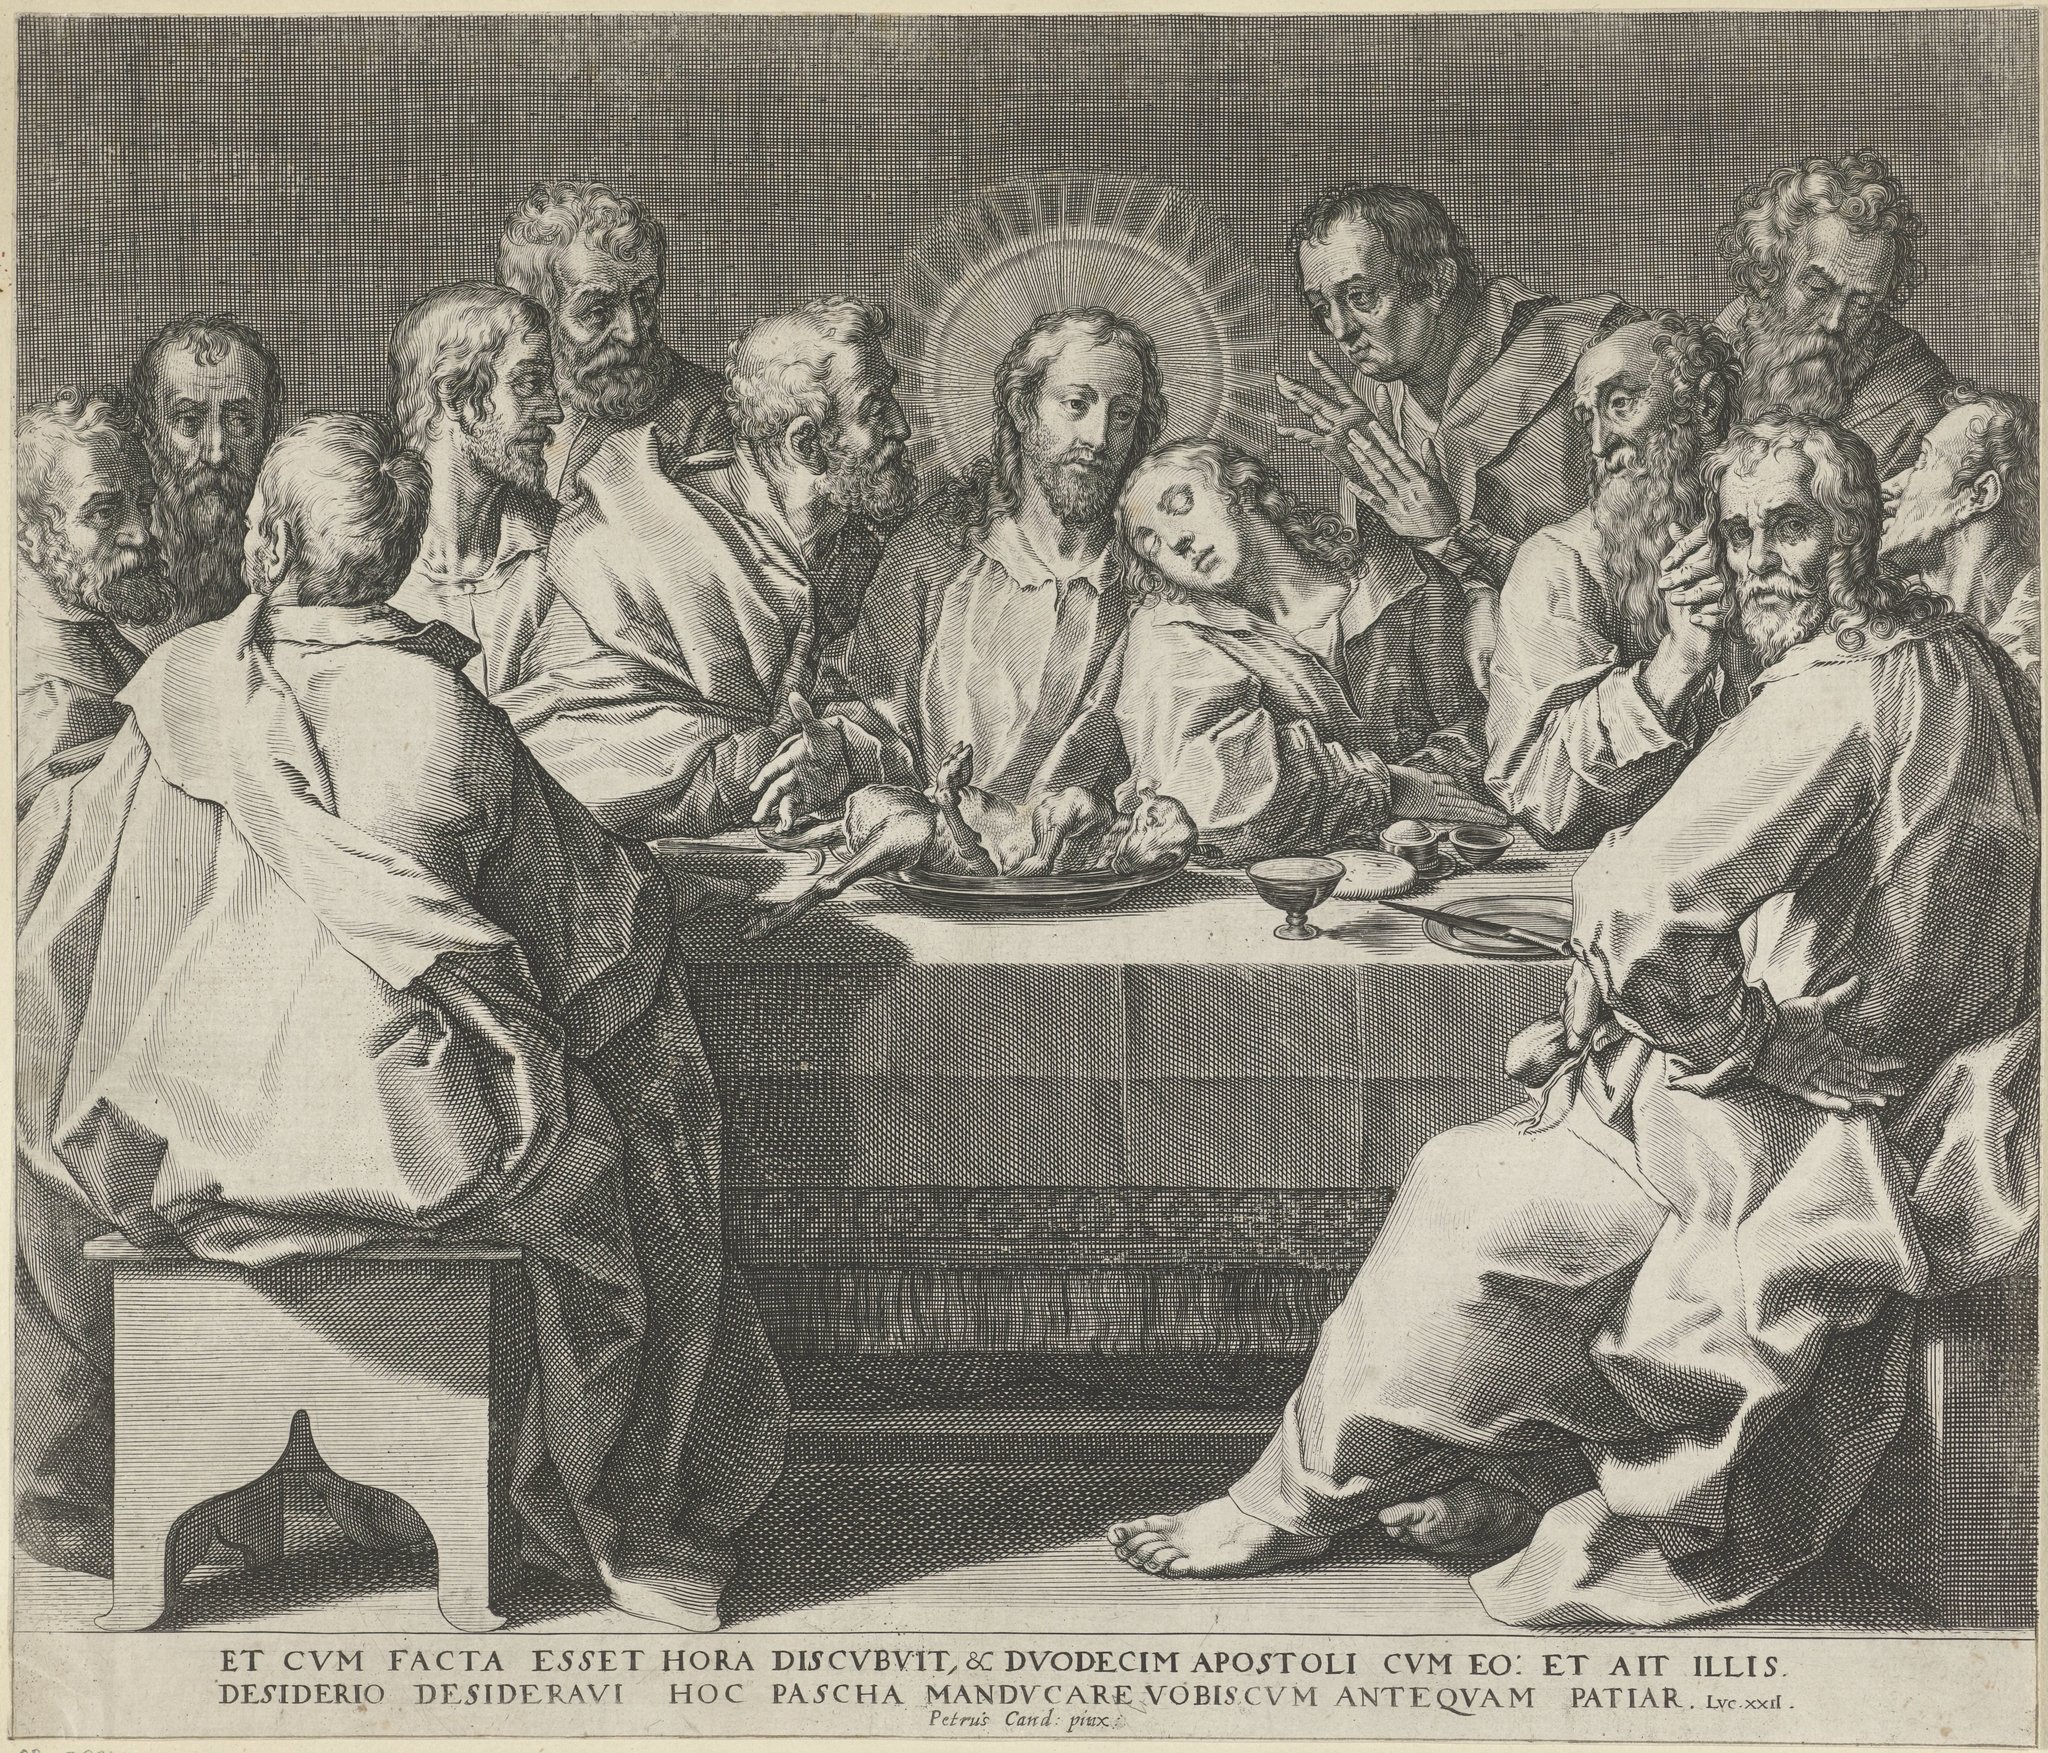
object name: print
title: Laatste Avondmaal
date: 1560-1650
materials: paper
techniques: engraving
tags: last supper (in general) (matthew 26:21-35; mark 14:18-31; luke 22:3, 22:15-23; john 13:21-38)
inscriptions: collector's mark: Lugt 240, caption: ‘P. de Witte: Candido’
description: Christus en zijn leerlingen rondom een rechthoekige tafel. Johannes met zijn hoofd op Christus' schouder. Judas, centraal vooraan, met een geldbuidel aan zijn gordel, symbool van zijn verraad. De prent heeft een Latijns onderschrift met een vers uit de Bijbel (Luc. 22).